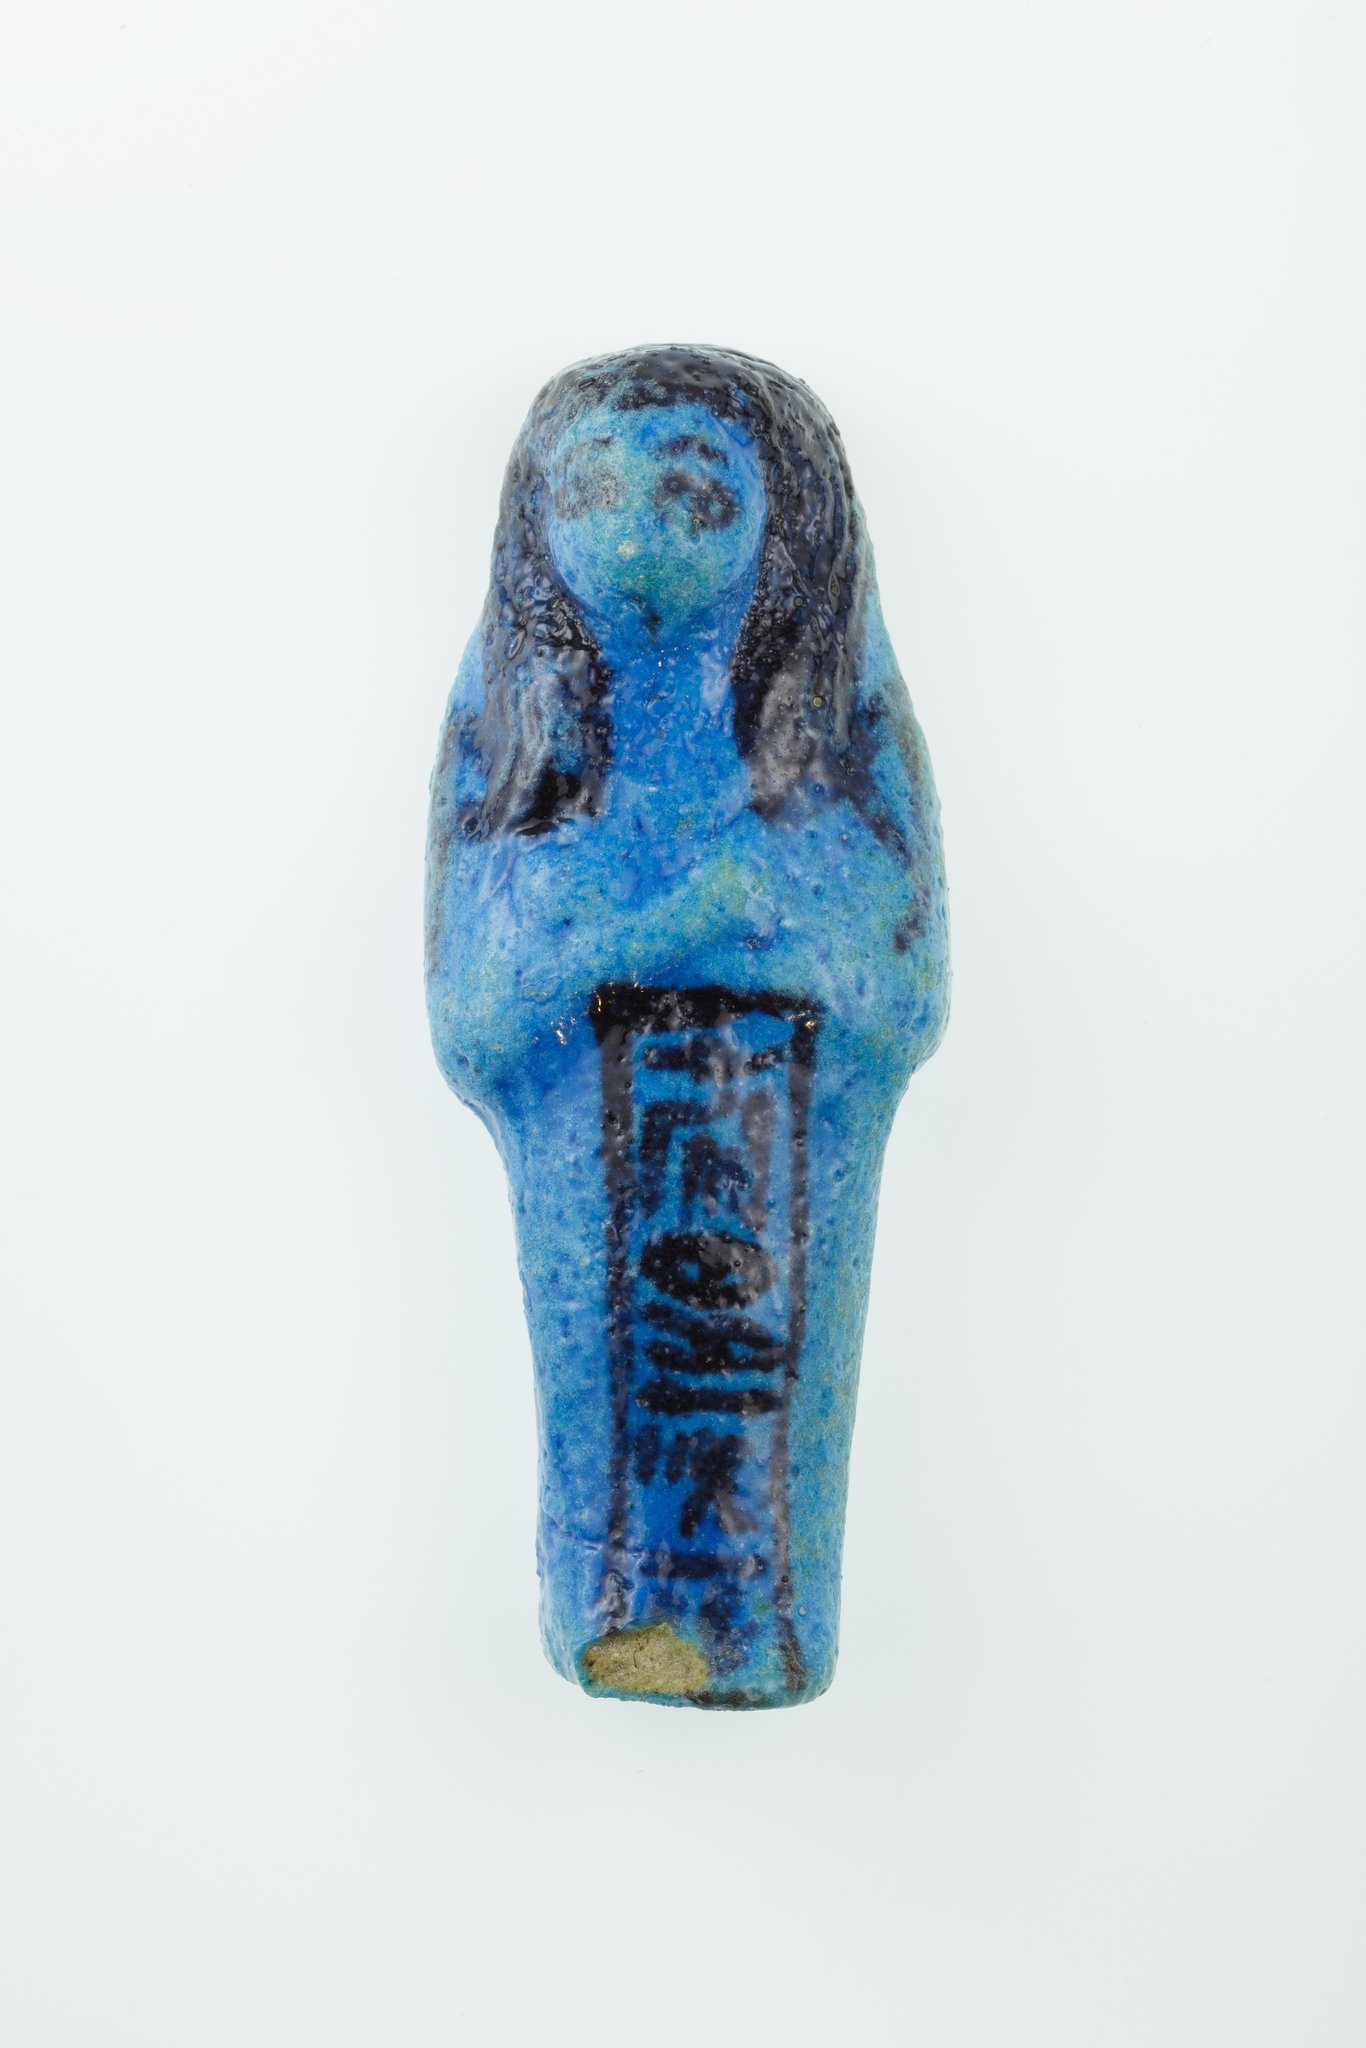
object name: shabti, worker, nauny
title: Worker Shabti of Nauny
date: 1050 BCE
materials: faience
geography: egypt